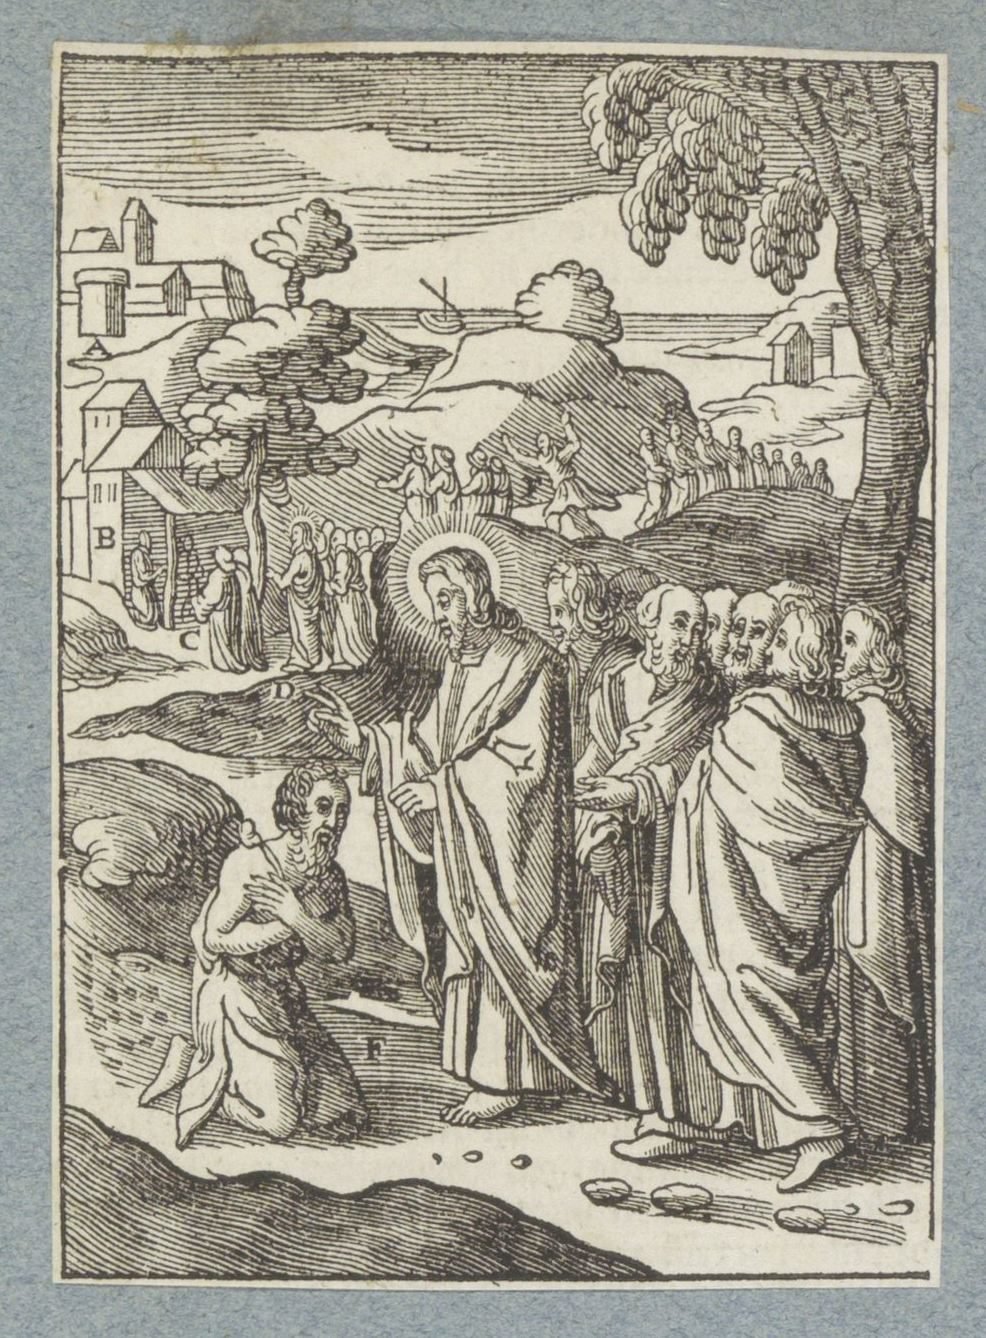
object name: album leaf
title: Christus geneest een melaatse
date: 1629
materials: paper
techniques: letterpress printing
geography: amsterdam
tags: healing of one leper, who kneels before christ (matthew 8:1-4; mark 1:40-45; luke 5:12-16)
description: De prent is afkomstig uit een van de uitgaven van P.J. Paets uit Amsterdam. Ze wordt voor het eerst gebruikt in: Der Zielen Lust-hof. Leuven, I.Jacbosz voor P.J. Paets [= Amsterdam, P.J. Paets], 1629. De voorstelling is gekopieerd naar een prent van Antonie II Wierix voor: Nadal, Jerónimo. Evangelicae Historiae Imagines. Antwerpen, M. Nutius, 1593.